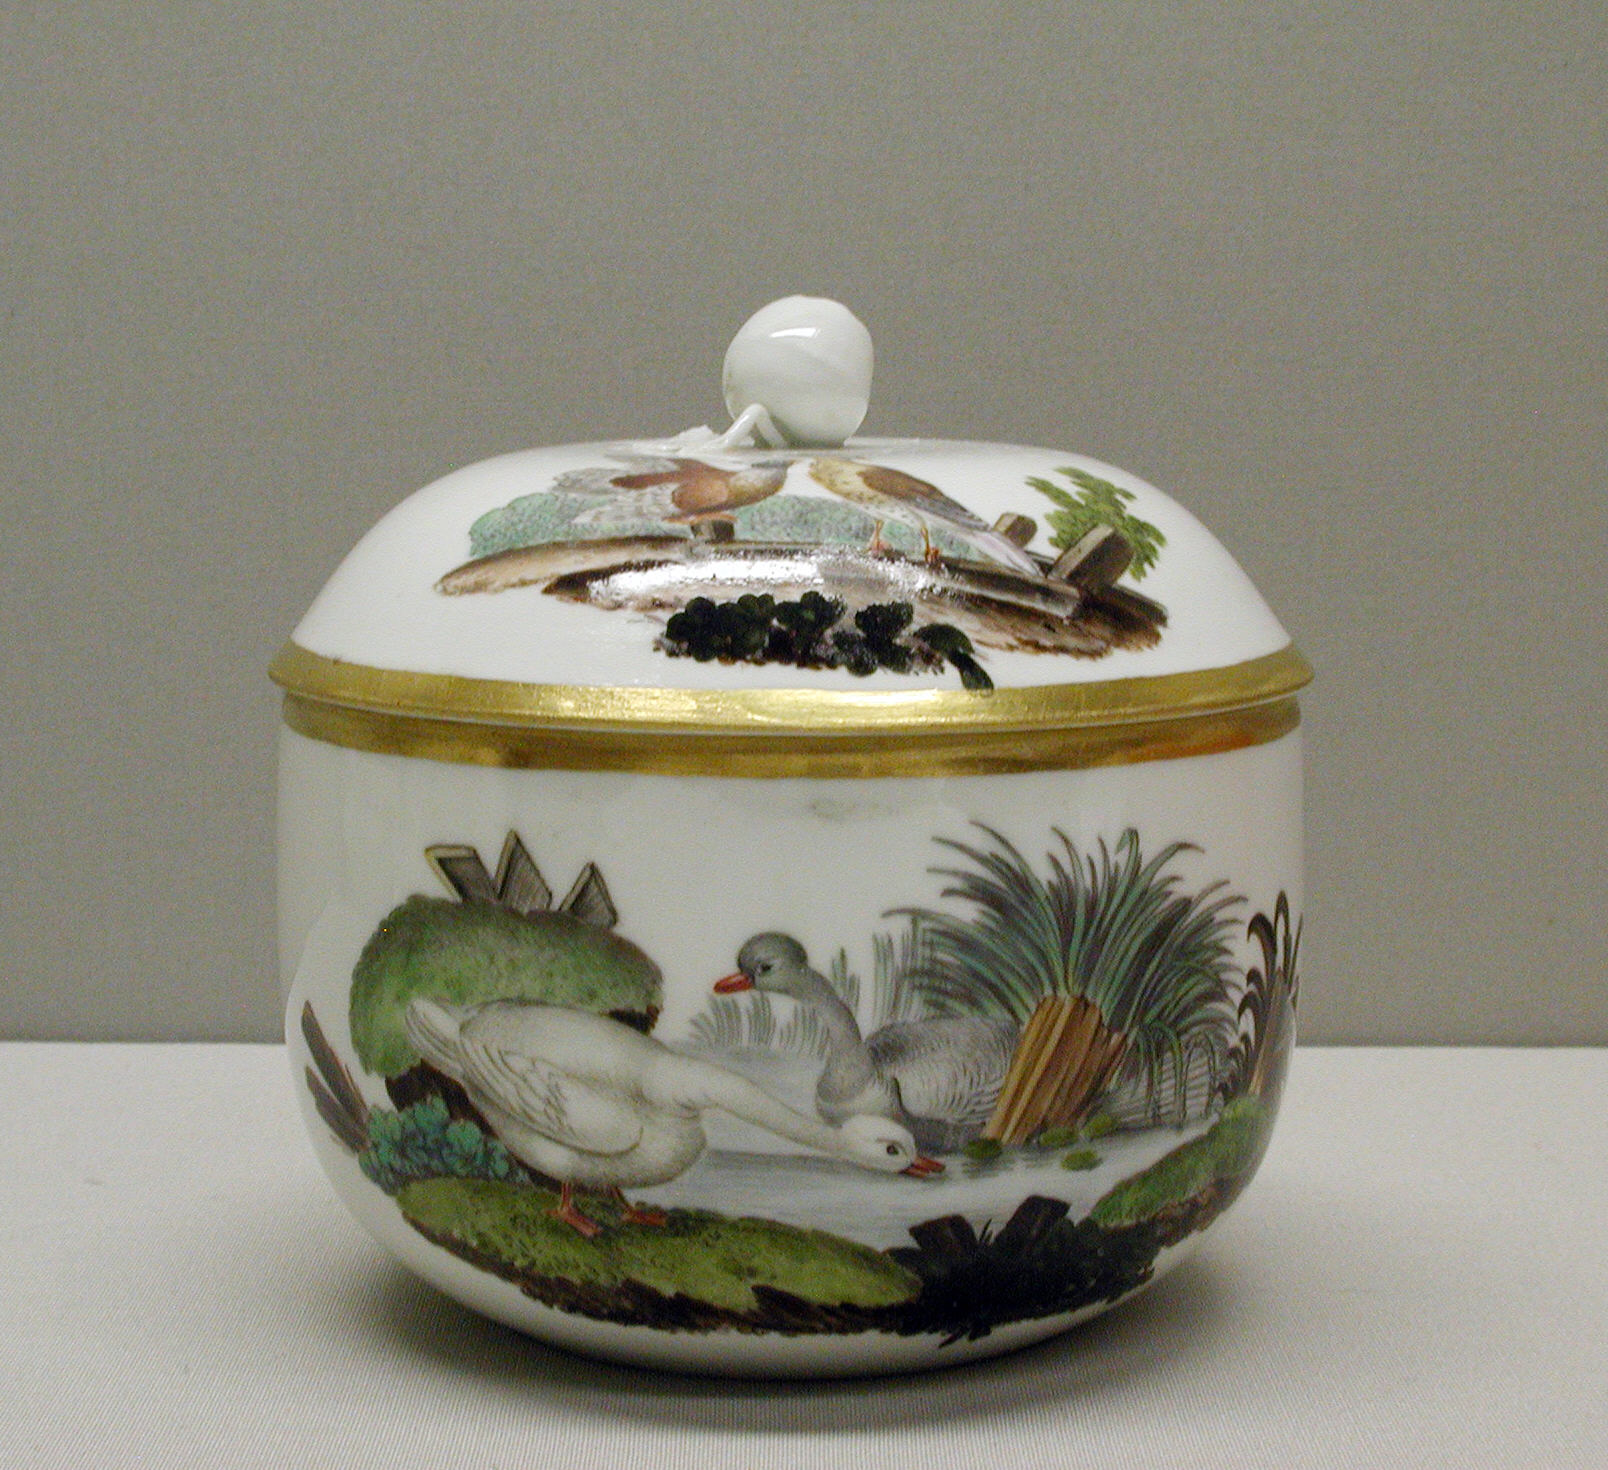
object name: sugar bowl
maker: höchst manufactory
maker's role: manufactory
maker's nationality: german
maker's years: 1746-1796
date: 1775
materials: hard paste porcelain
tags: birds,ducks